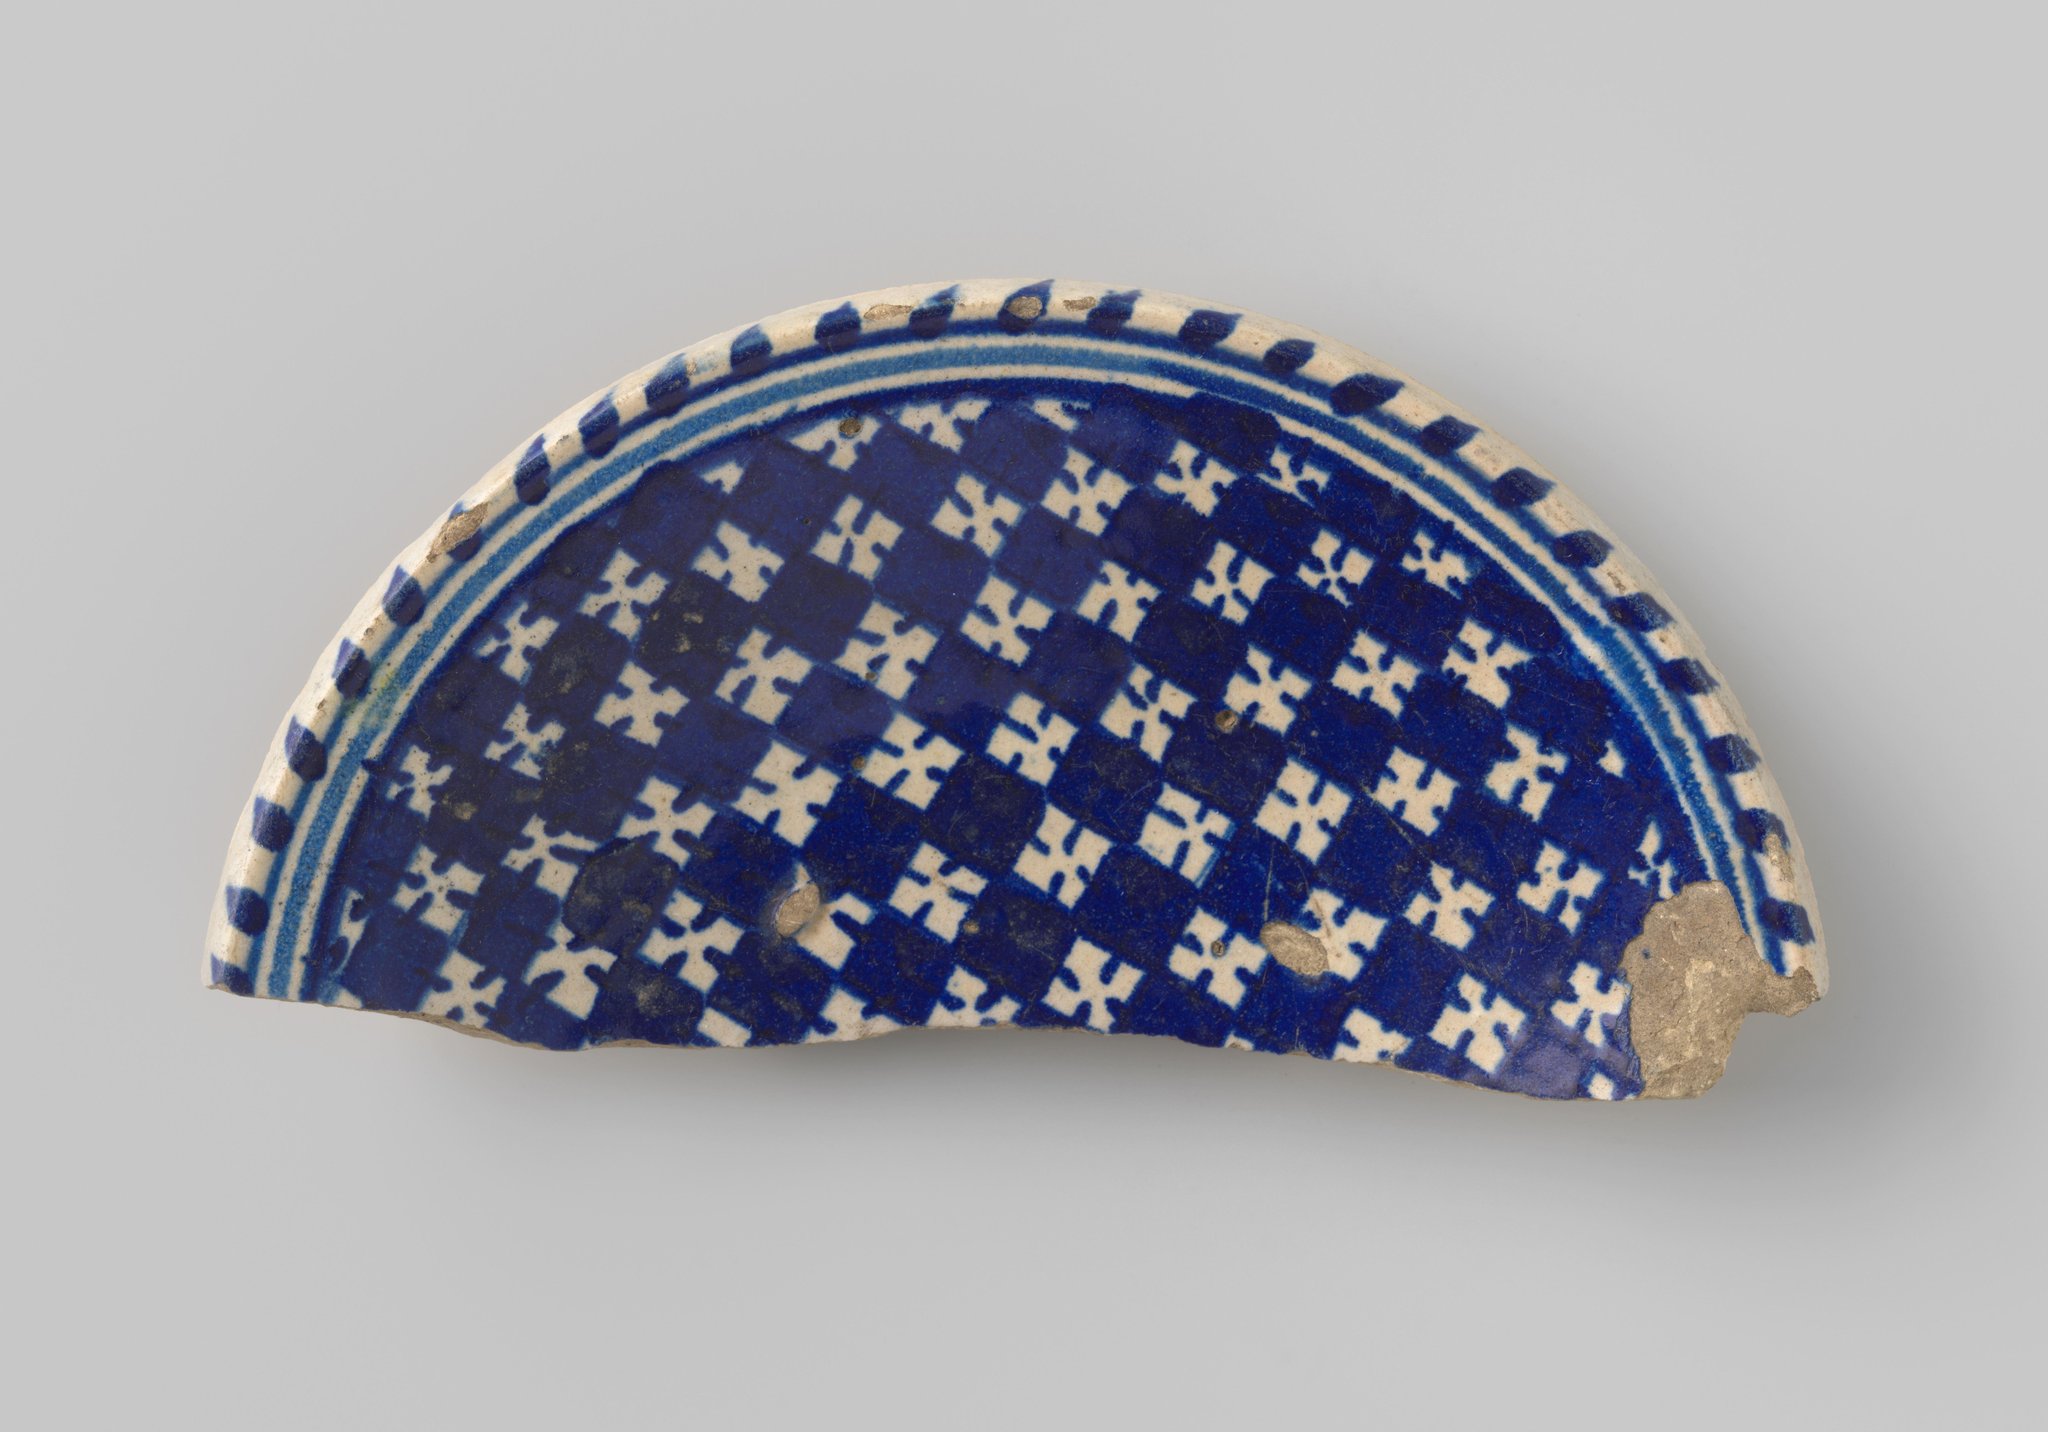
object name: vessel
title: Fragment van een schotel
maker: Anonymous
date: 1600-1610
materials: earthenware, glaze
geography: northern netherlands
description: Fragment van een ronde schotel van aardewerk. De zachte geel-witte scherf is aan voorzijde met lichtgrijs tinglazuur, aan de achterzijde met loodglazuur gedekt. Hierop is de voorzijde met donkerblauw zodanig beschilderd dat een doorlopend ornament is ontstaan van afwisselende blauwe en witte, vierkante vakjes. De witte vakjes zijn door intekening van blauwe lijntjes vaak tot blaadjes geworden. het geheel is door twee smalle, blauwe cirkellijnen en een rand van blauwe strepen omsloten. Noordelijke Nederlanden, Delft? Afkomstig uit Keulen.